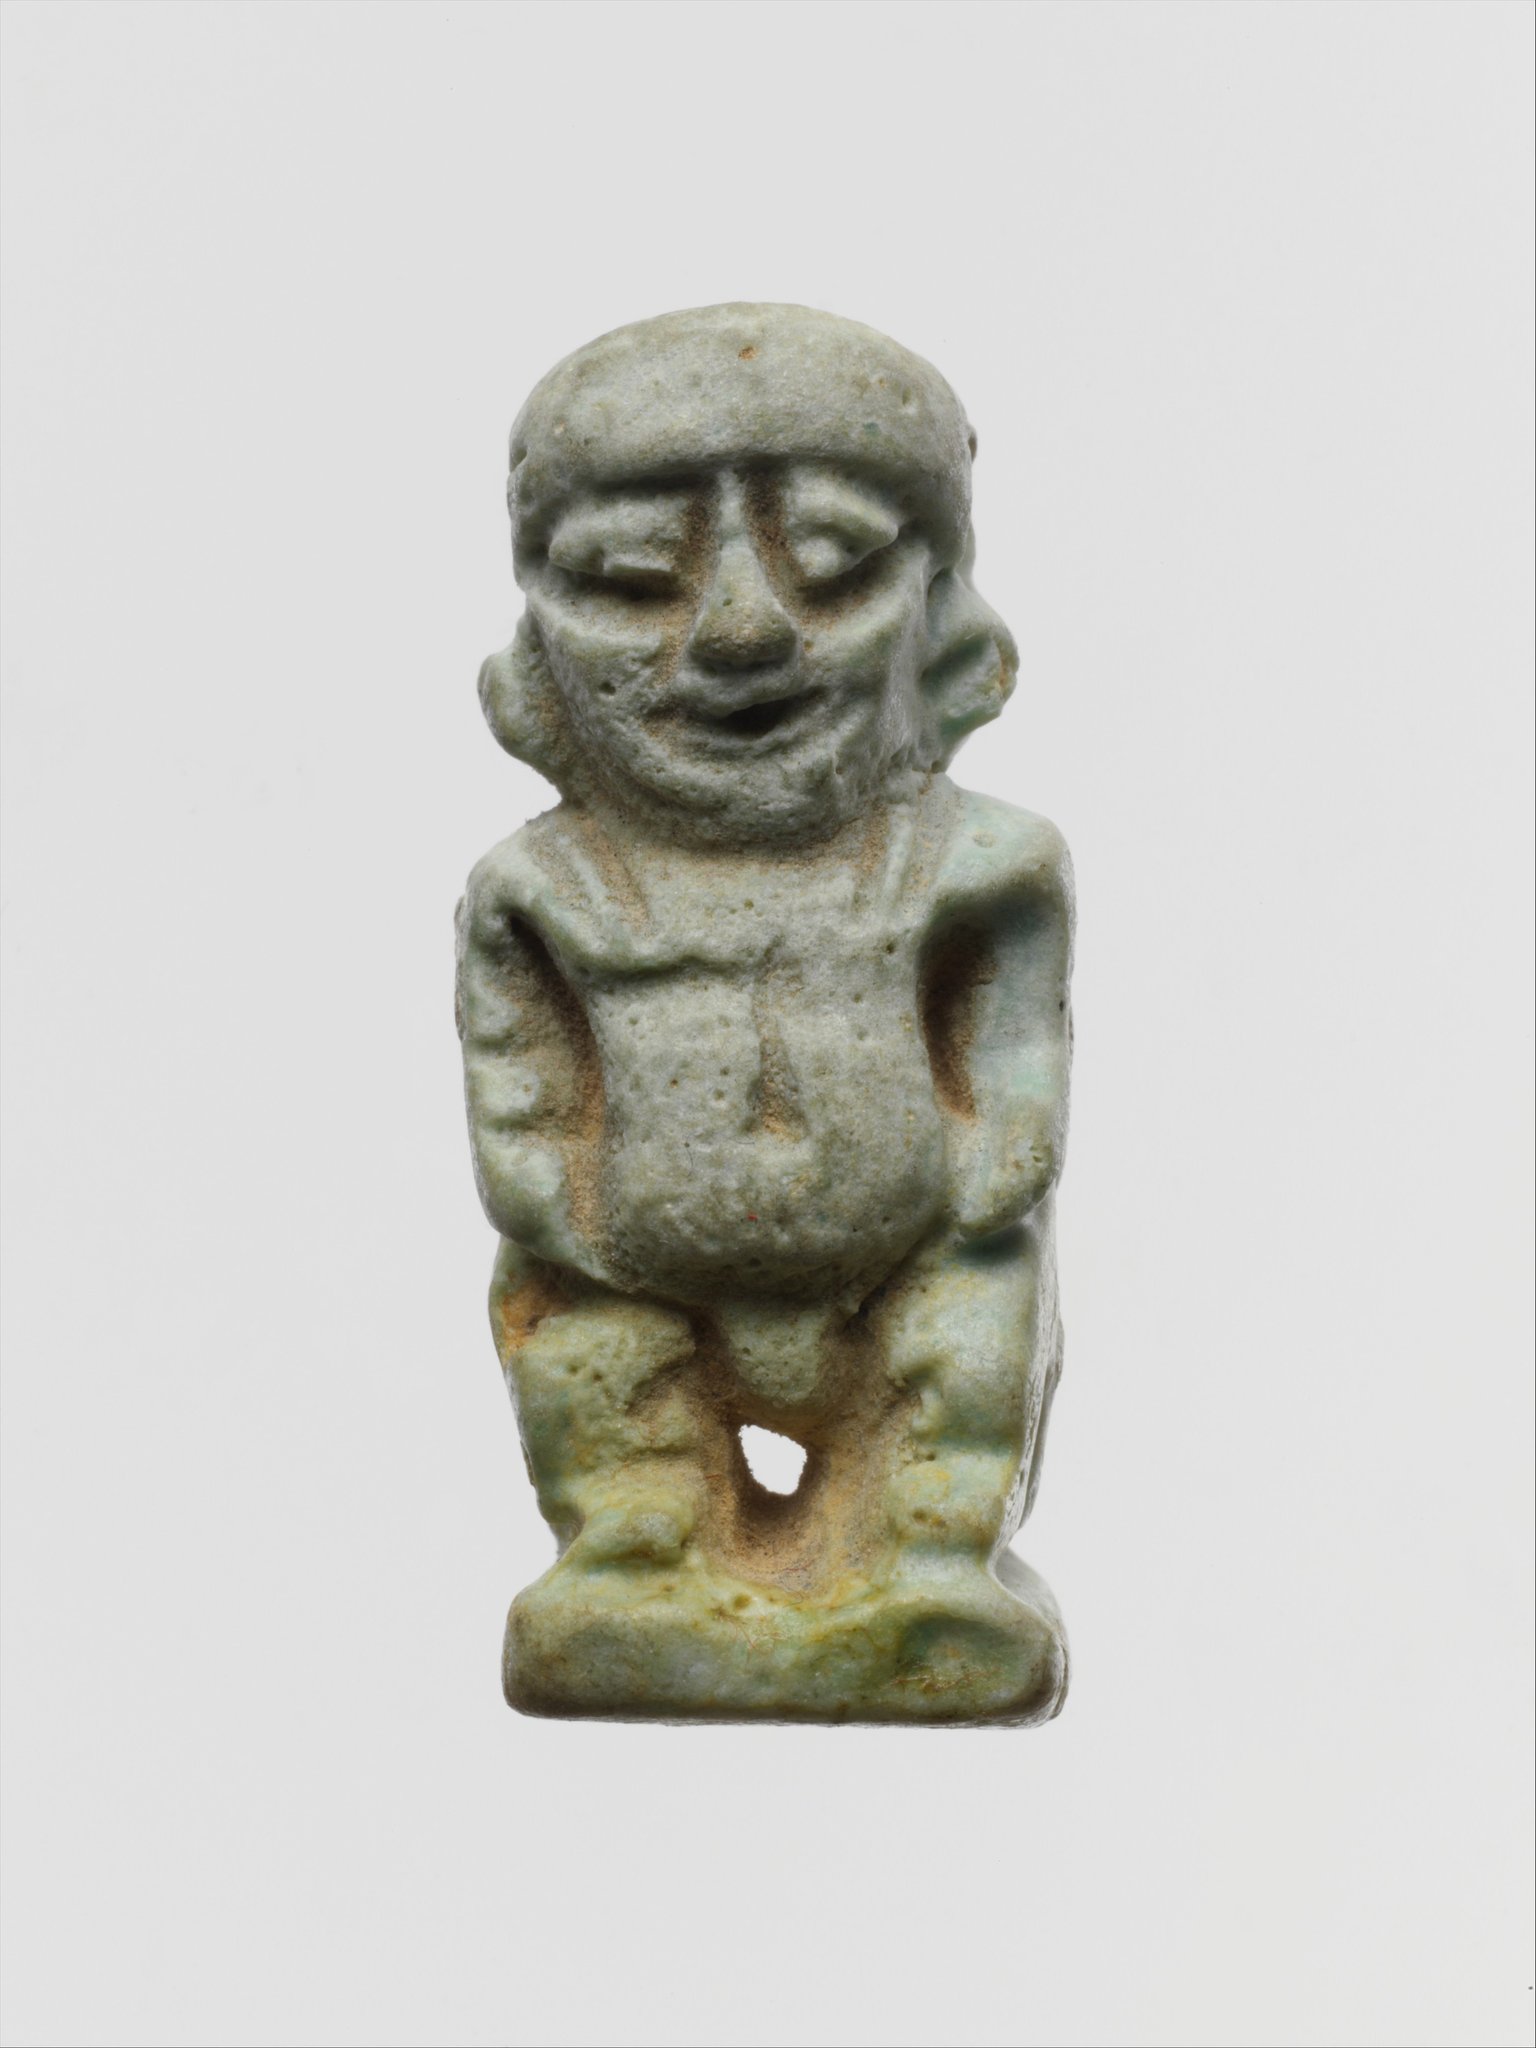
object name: amulet, ptah seker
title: Faience two-sided amulet in the form of the dwarf god Pataikos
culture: egyptian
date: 1090-900 BCE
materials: faience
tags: gods